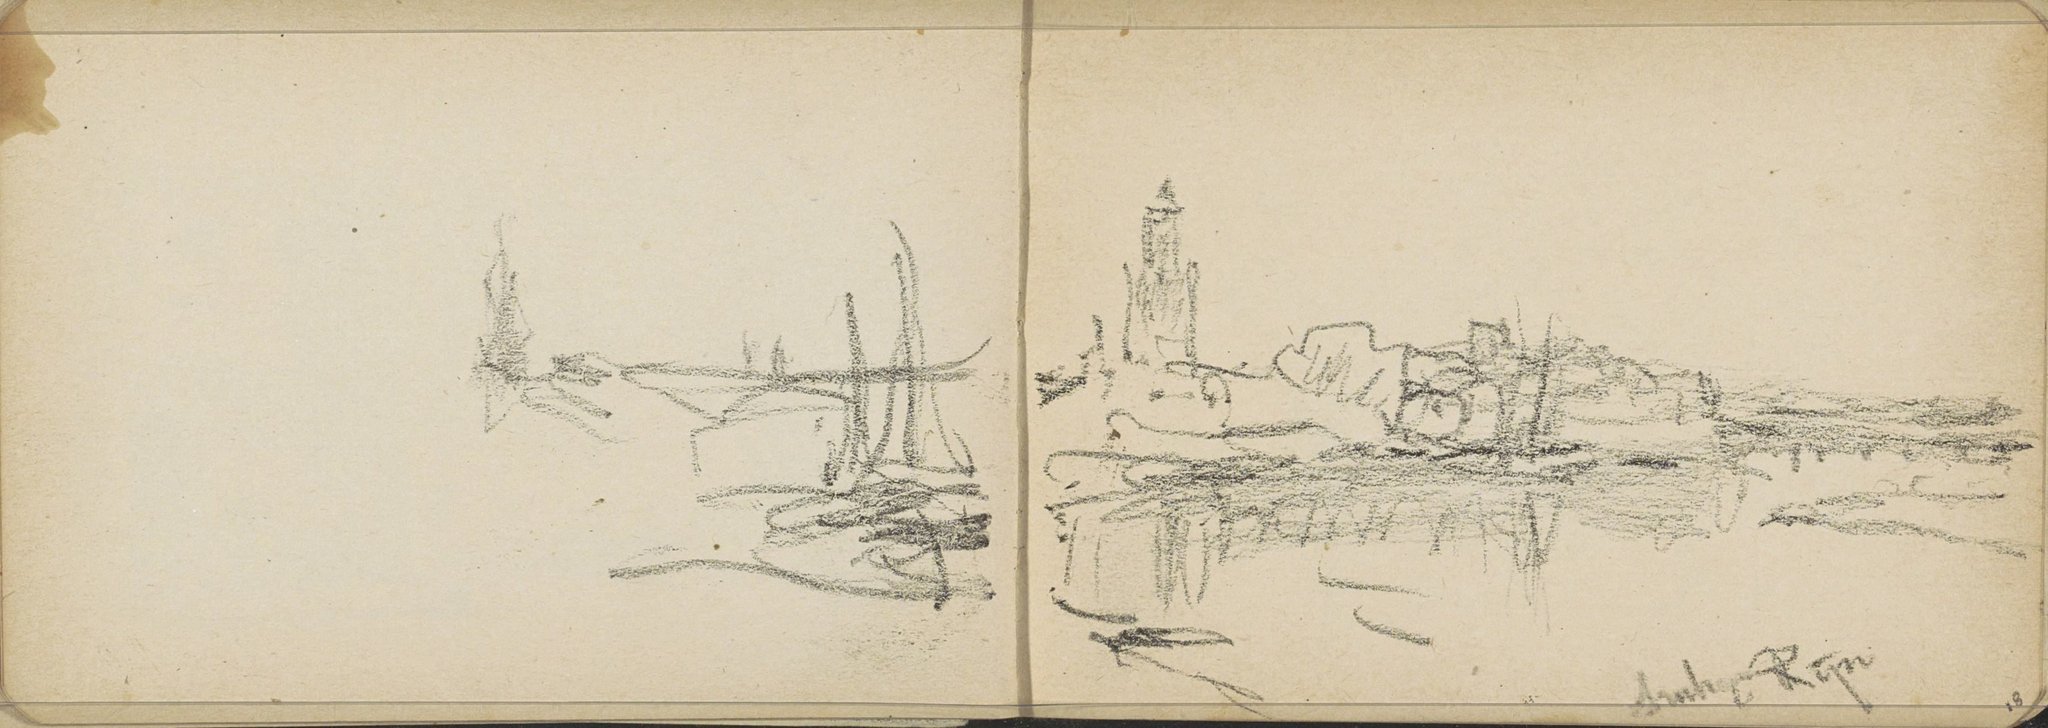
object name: sketchbook leaf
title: Gezicht op Arnhem aan de Rijn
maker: willem cornelis rip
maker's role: draughtsman, painter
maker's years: 1856-1922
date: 1919-1921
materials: chalk, paper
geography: arnhem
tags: city-view, and landscape with man-made constructions, river, arnhem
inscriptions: annotation: ‘ArnhemRijn’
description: Gezicht op de stad met onder andere de toren van de Sint-Eusebiuskerk. Blad 17 verso en 18 recto uit een schetsboek met 42 bladen.